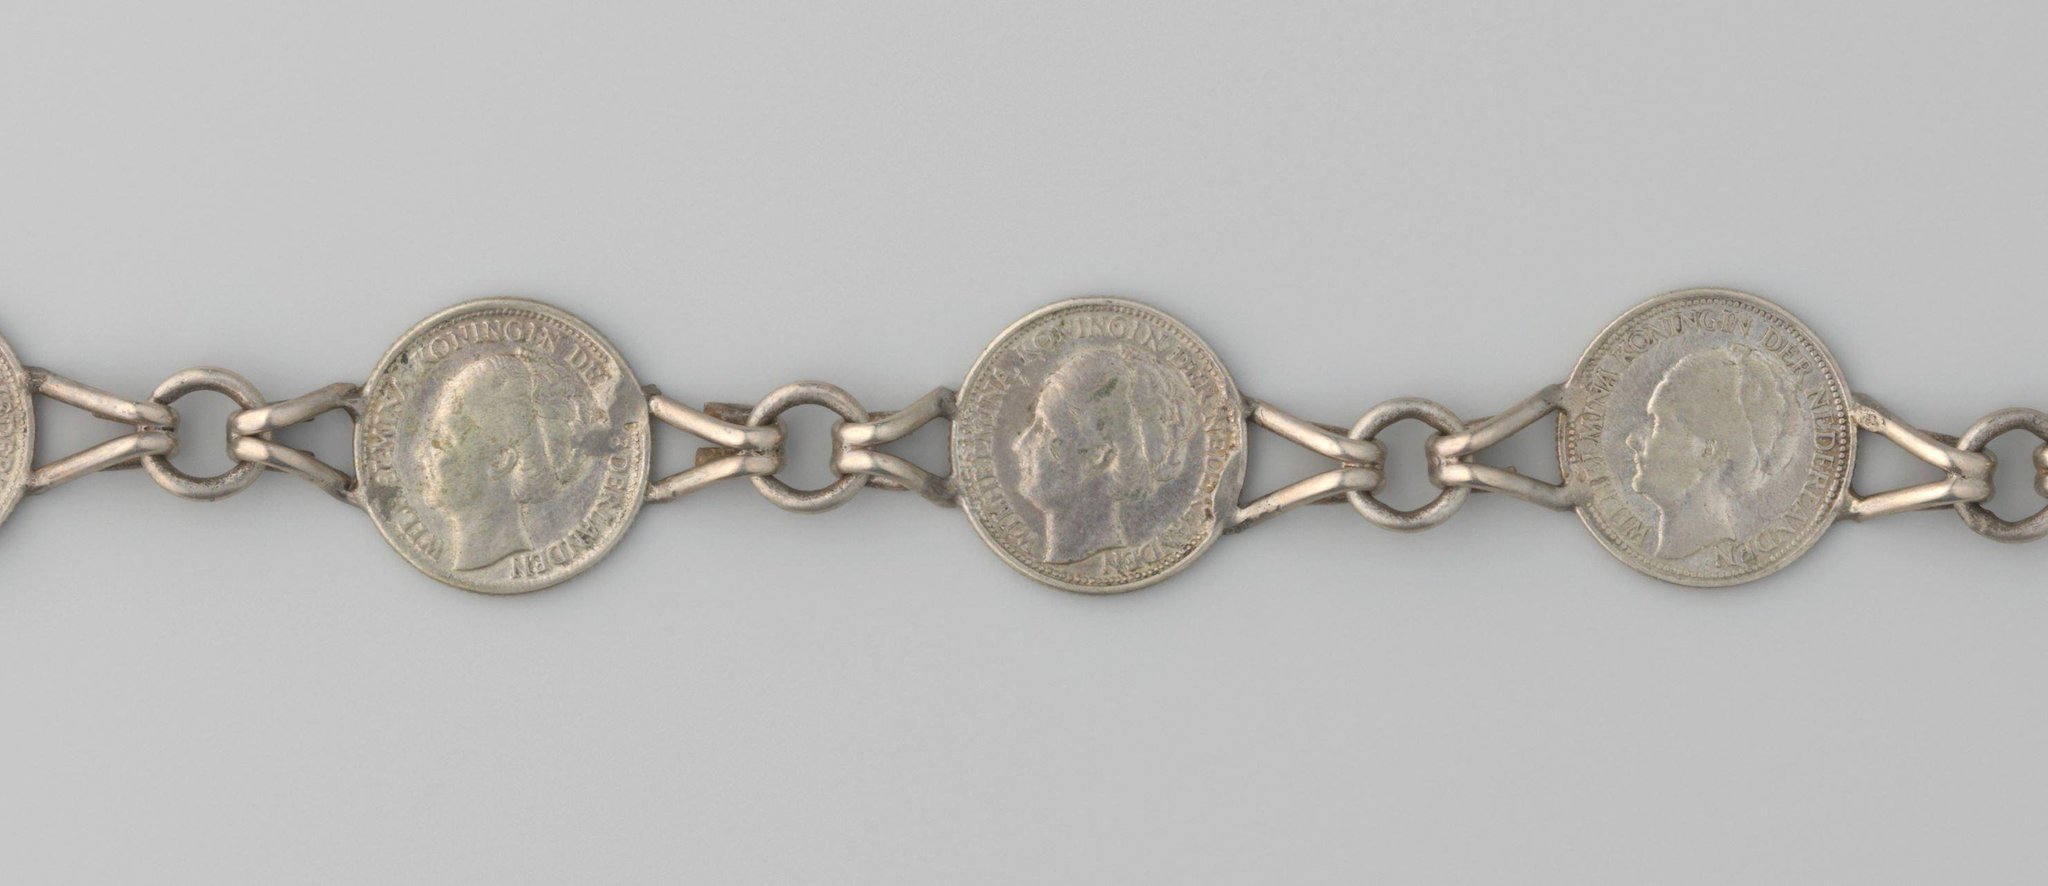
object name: bracelet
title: Zilveren armband van vijf kwartjes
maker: Anonymous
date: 1940-1950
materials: silver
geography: netherlands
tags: the hague, print maker, wilhelmina of the netherlands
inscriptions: maker's mark, alloy mark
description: Zilveren armband van vijf kwartjes verbonden door v-vormig draad en ronde ogen voorzien van een haaksluiting.